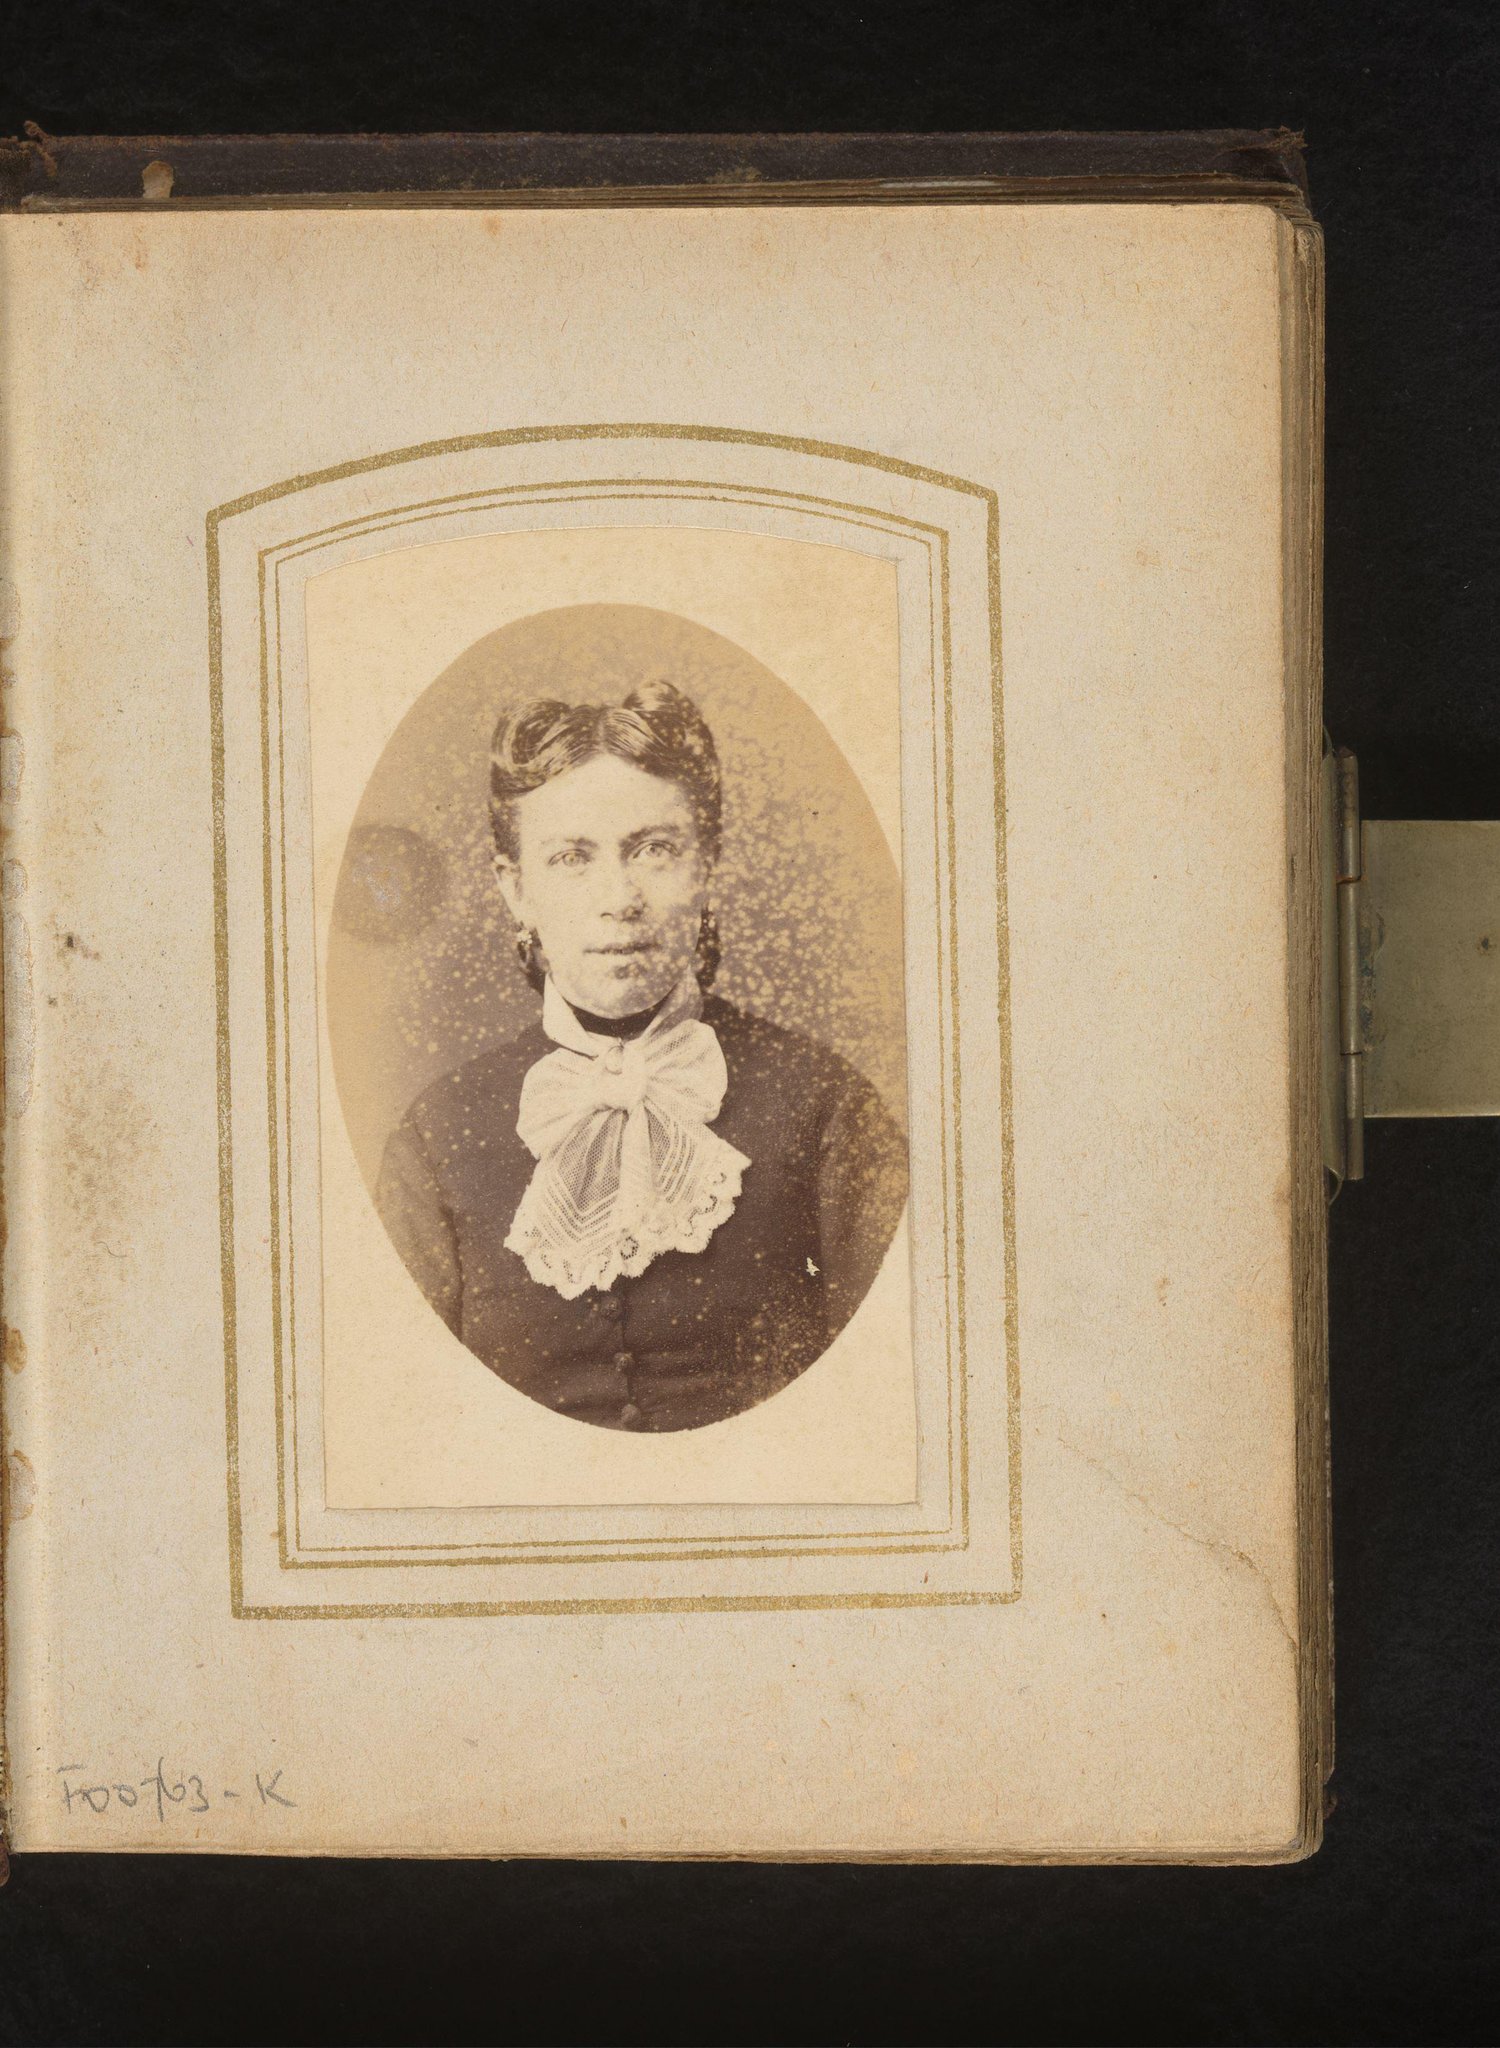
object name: carte de visite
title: Portret van een vrouw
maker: dirk niekerk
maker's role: fotograaf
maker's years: 1824-1881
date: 1875-1881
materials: cardboard, photographic support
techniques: albumen print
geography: amsterdam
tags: historical persons - bb - woman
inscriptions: inscription: ‘NATIONALE/ 1875/ TENTOONSTELLING./ D. NIEKERK/ Photograaf van Z.K.H. Prins Hendrik/ der Nederlanden,/ Kadijksplein U, 9/ AMSTERDAM.’